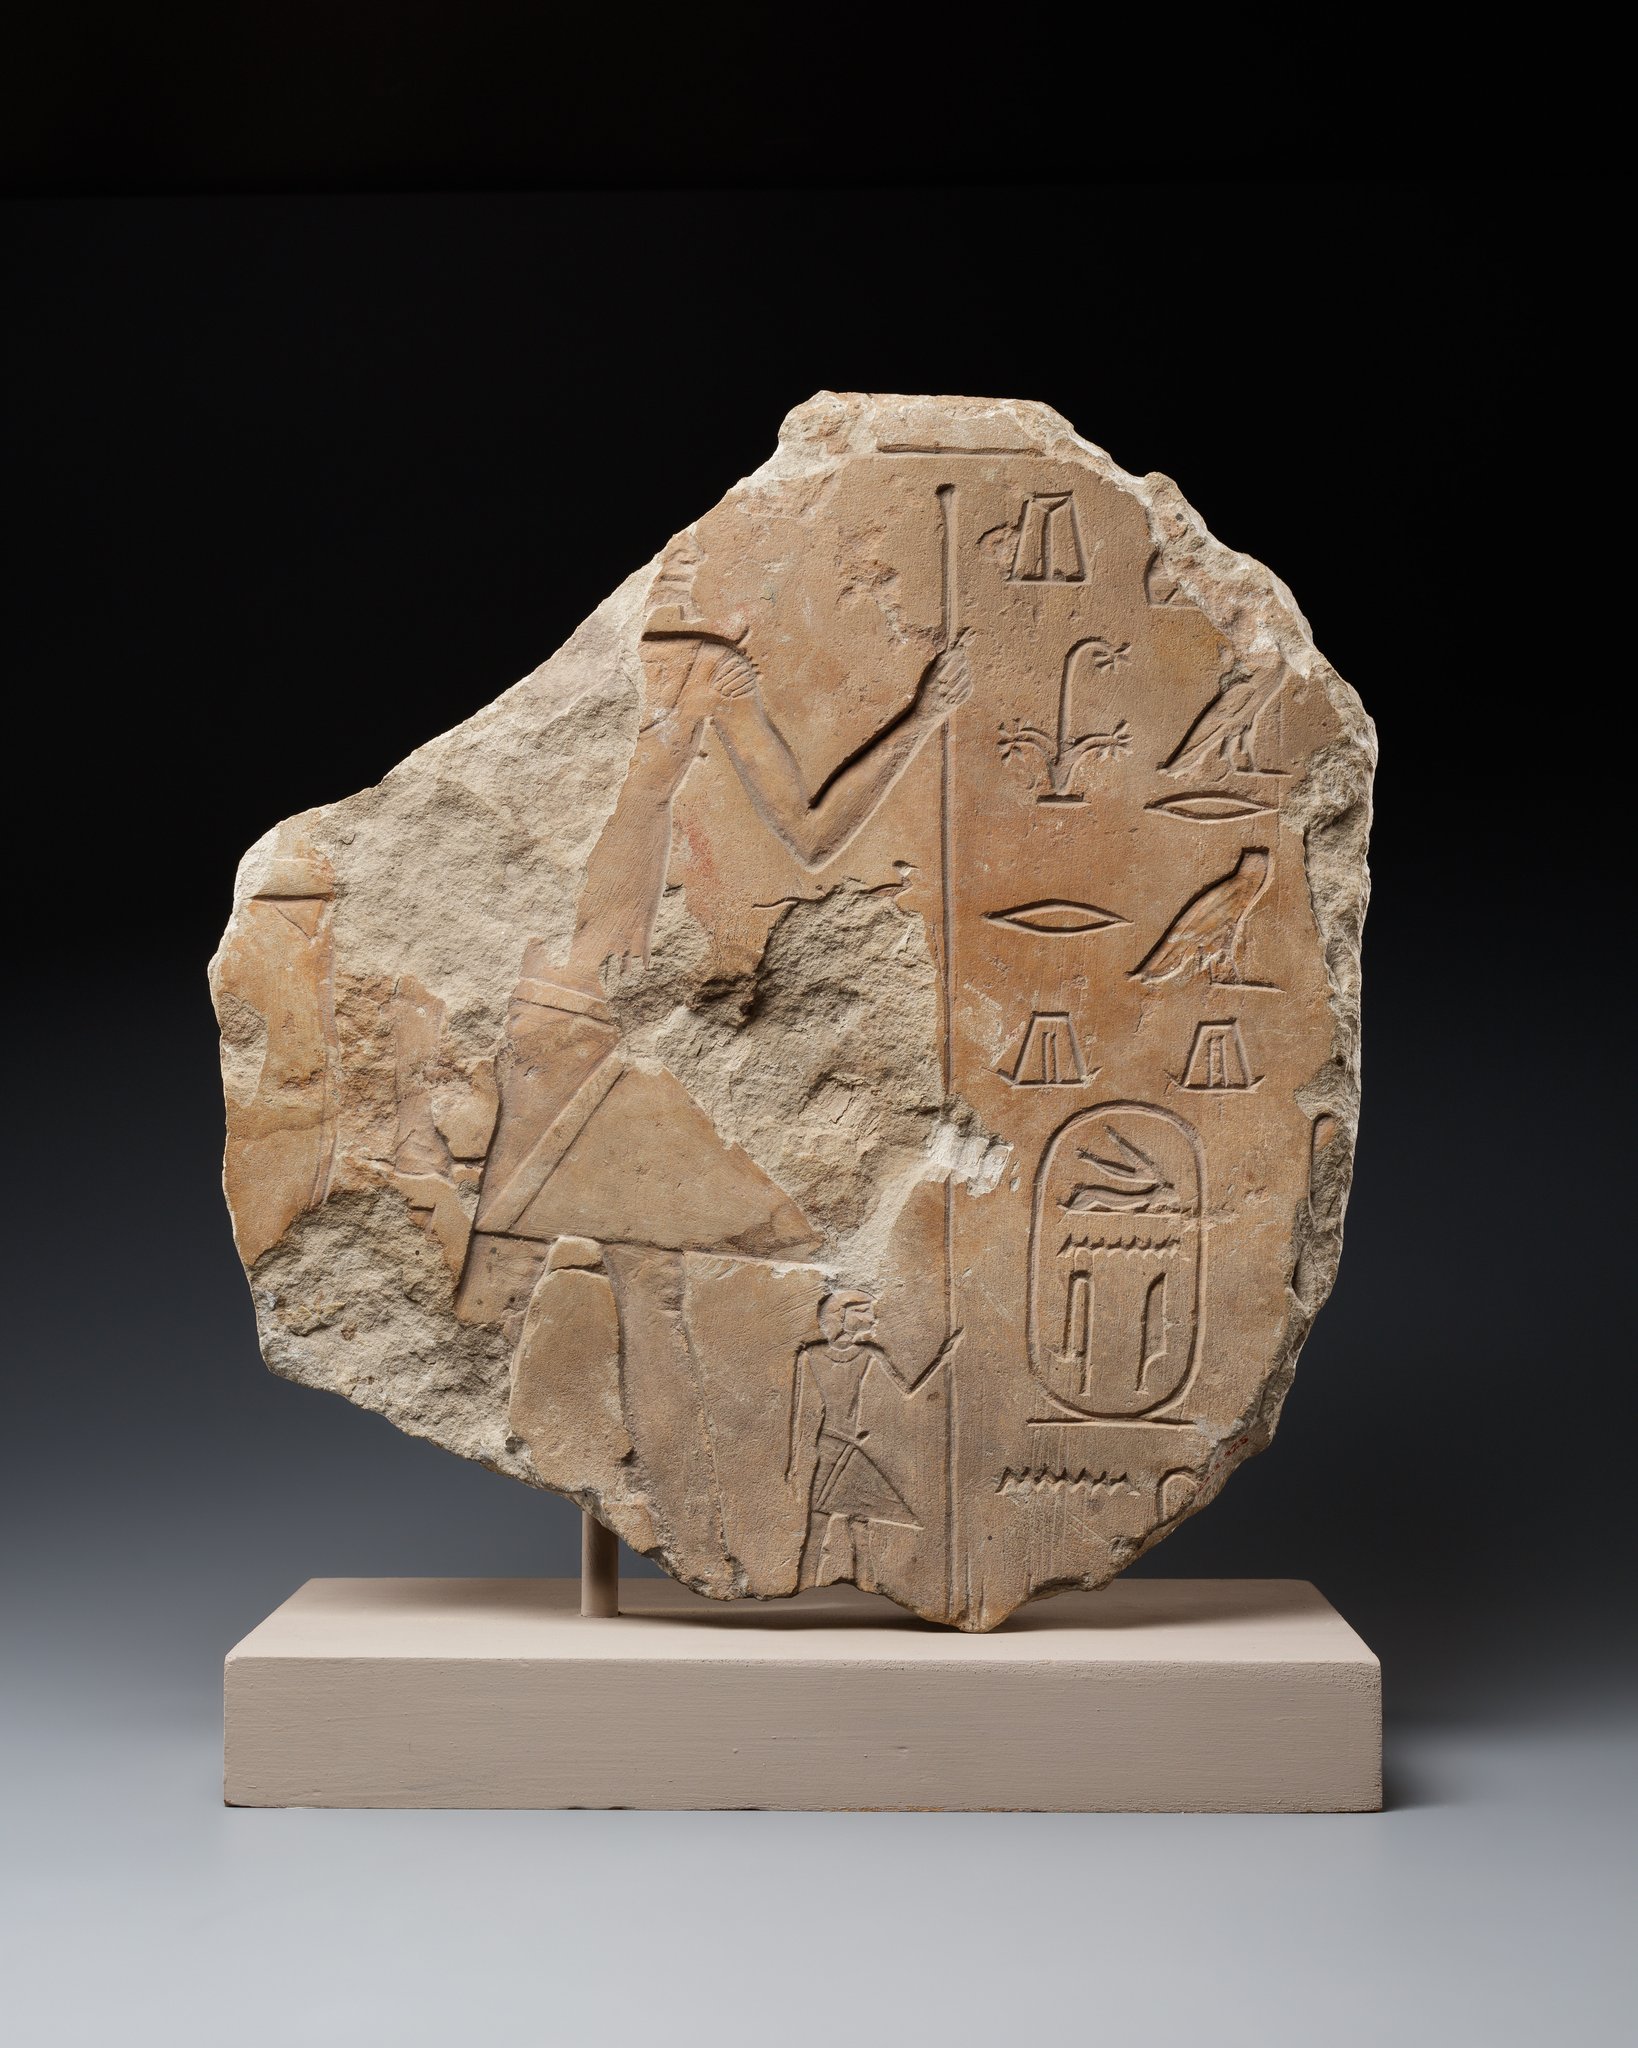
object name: relief fragment, figure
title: Fragment of relief with a figure?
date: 2649-2100 BCE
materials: limestone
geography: egypt